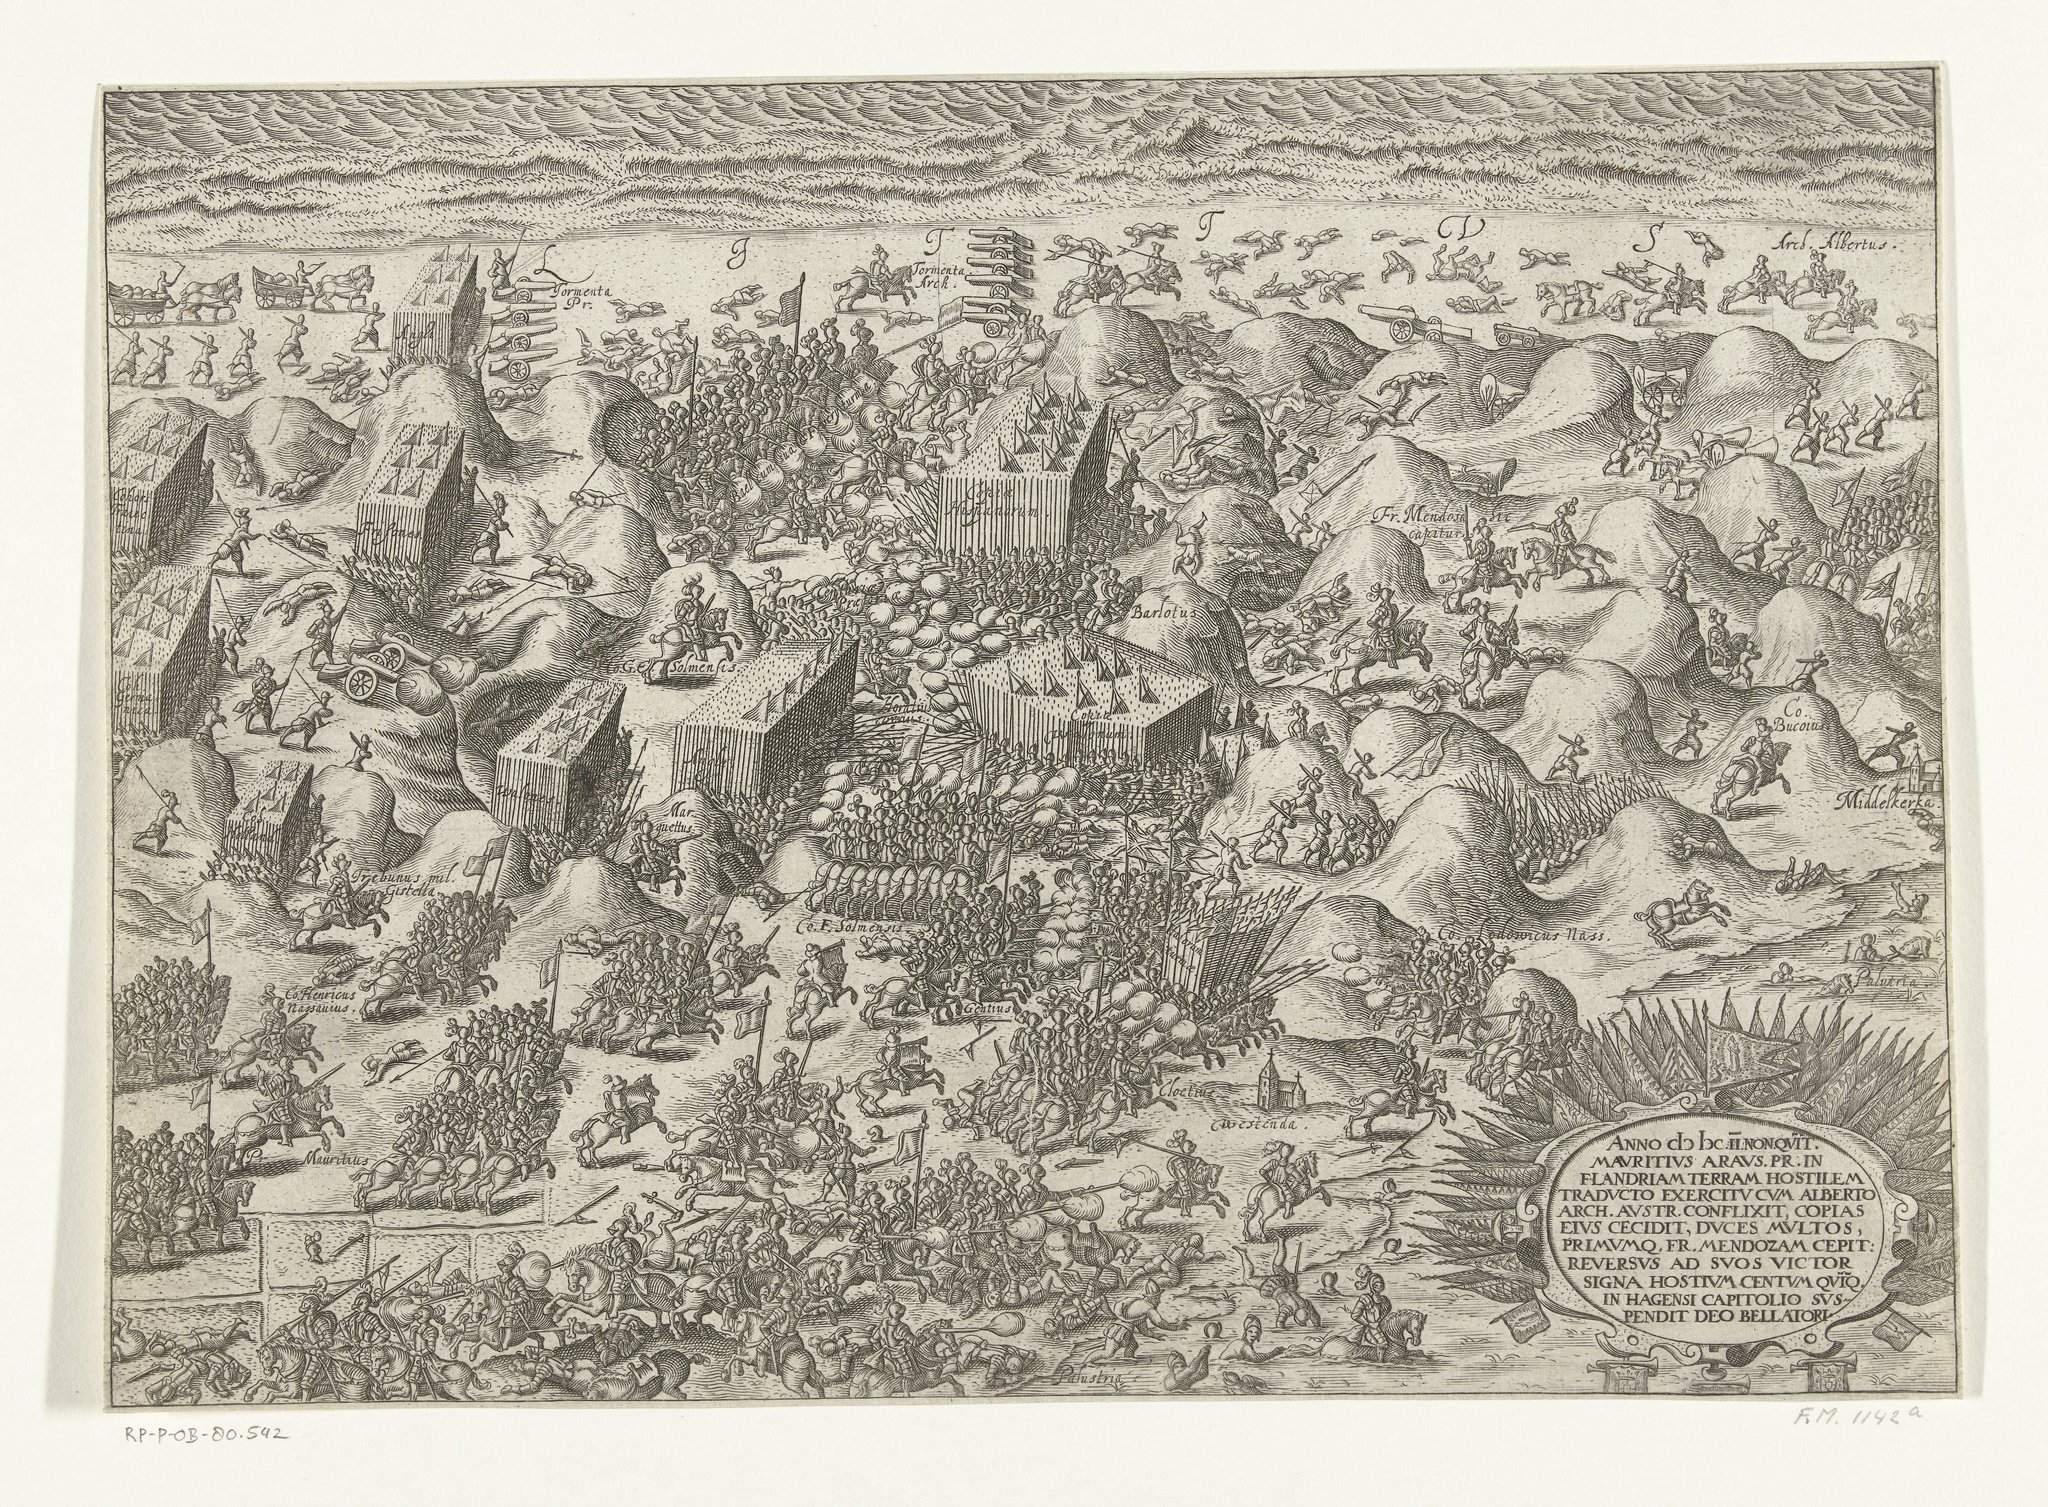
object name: print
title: Slag bij Nieuwpoort, 1600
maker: bartholomeus willemsz. dolendo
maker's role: print maker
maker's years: 1560-1626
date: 1600-1601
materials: paper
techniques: engraving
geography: northern netherlands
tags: the hague, maurice (prince of orange), brussels, albrecht aartshertog van oostenrijk, battle (+ land forces), battle of nieuwpoort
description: Gebruikt als illustratie in: J.J. Orlers, Den Nassauschen Lauren-Crans: Beschrijvinghe ende af-beeldinge van alle de victorien ... die Godt Almachtich de ... Staten der Vereenichde Nederlanden verleent heeft, deur het wijs ende clouck beleyt des Hooch-ghebooren Fursts Maurits van Nassau, J.J. Orlers en H. van Haestens, Leiden 1610, fol. 152/153.